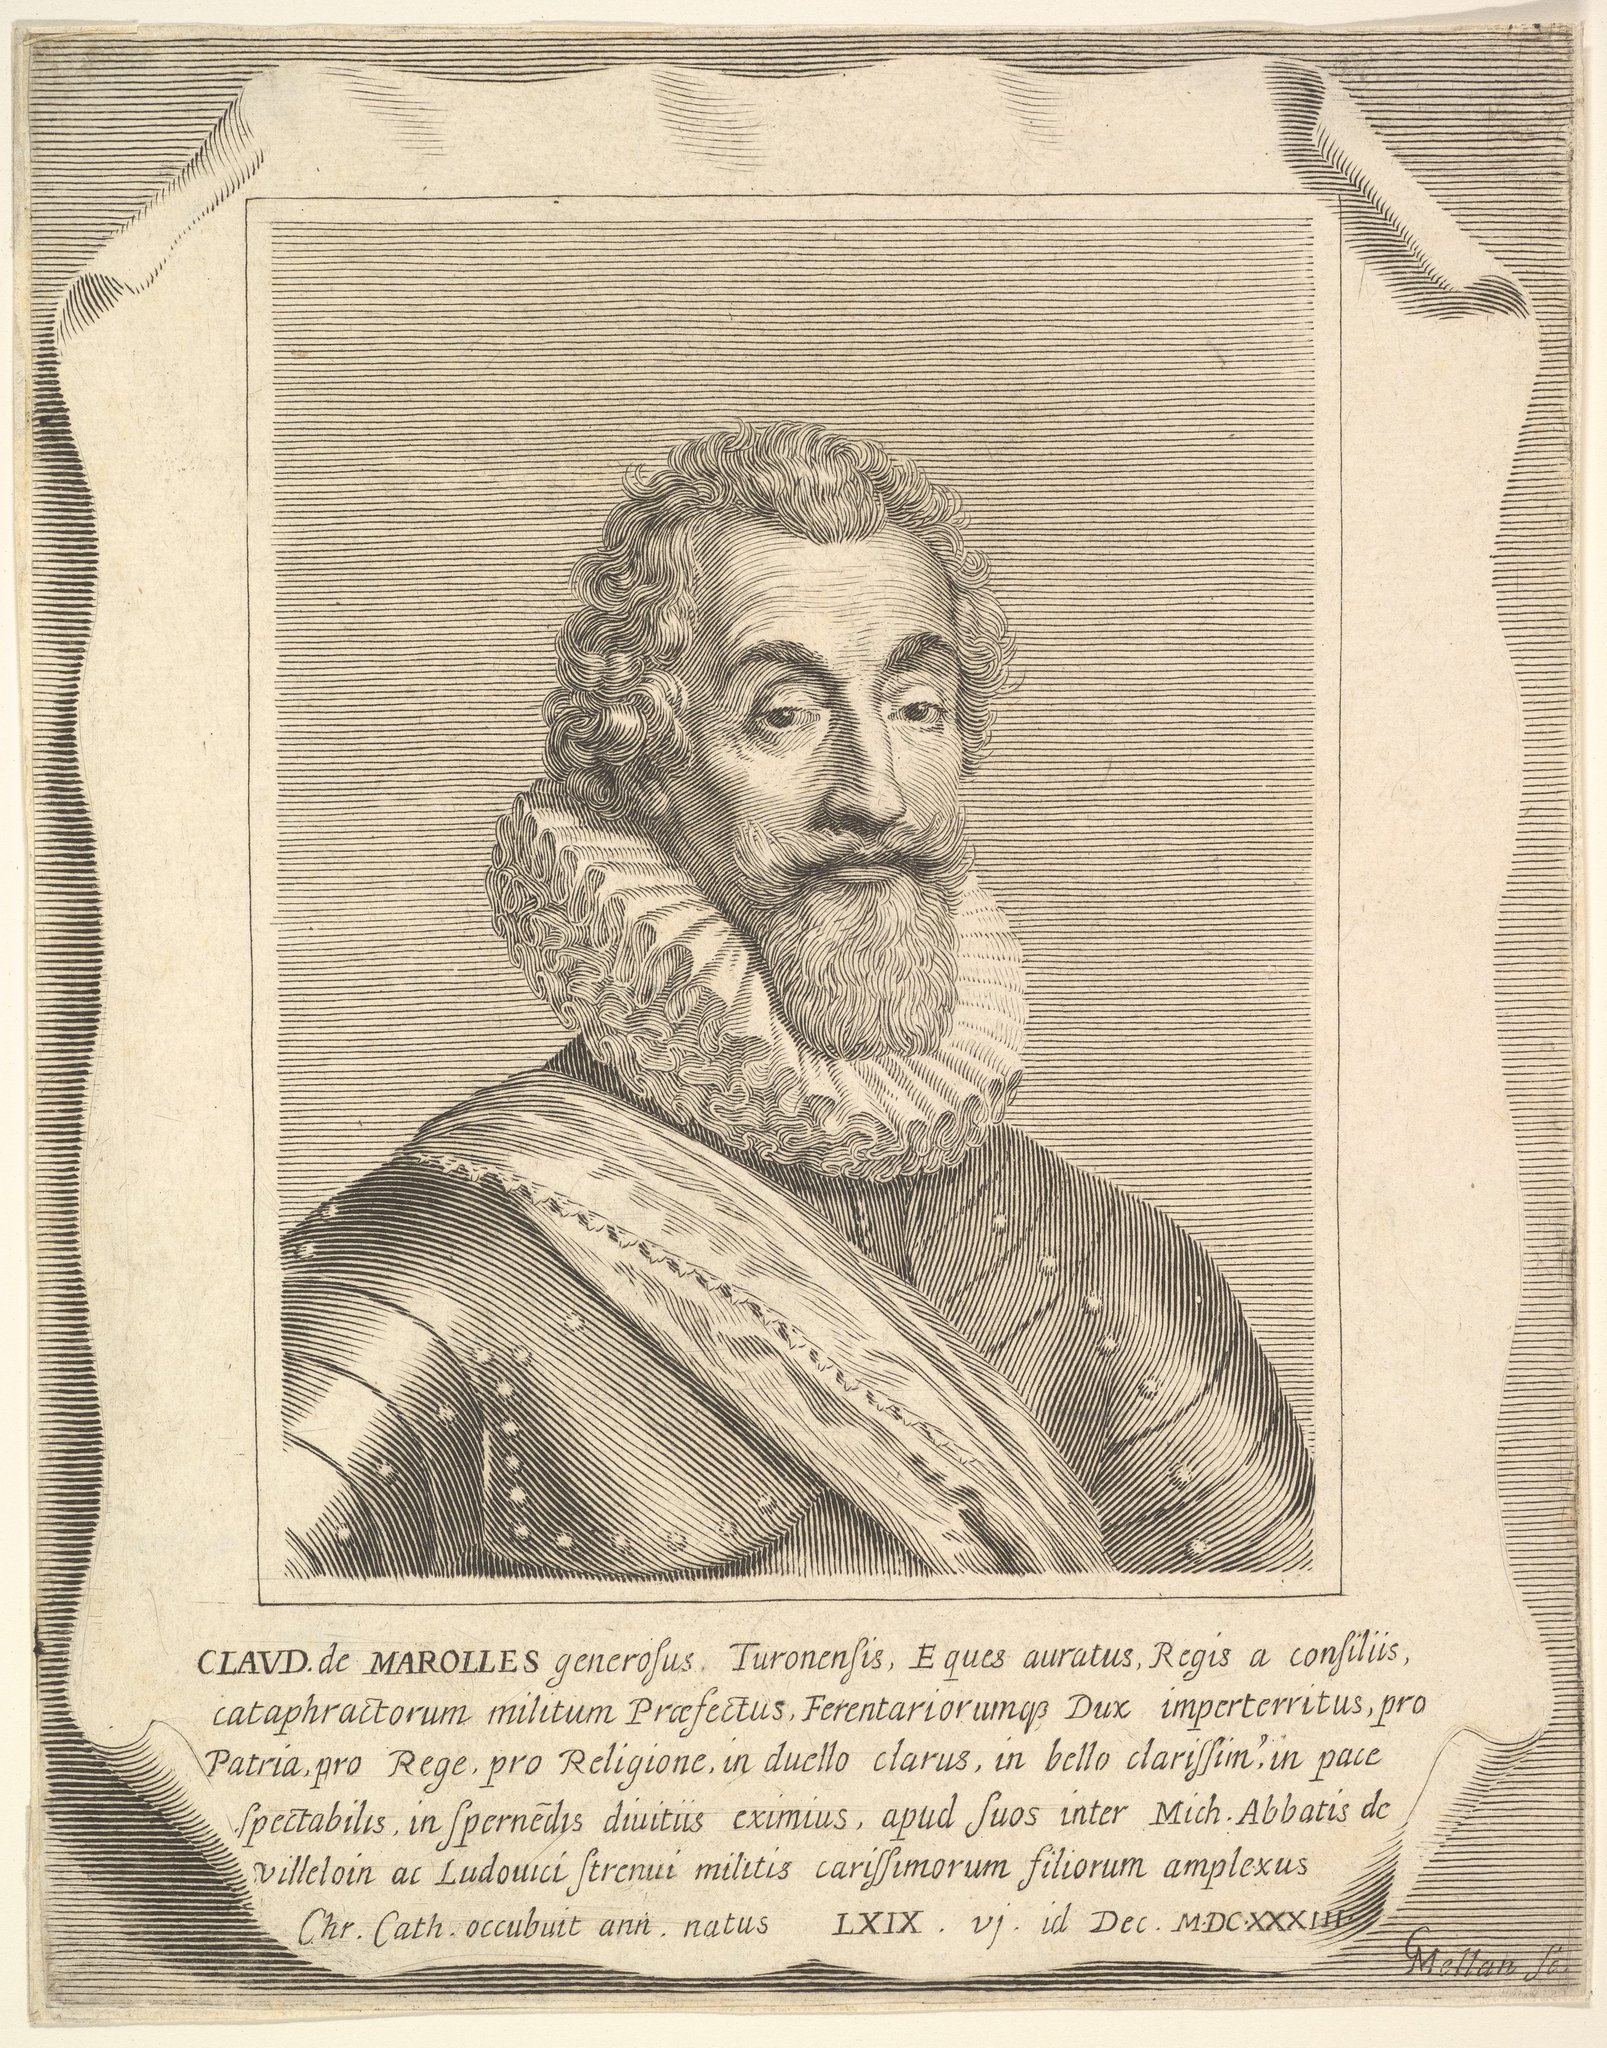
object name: print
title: Portrait of Claude de Marolles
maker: claude mellan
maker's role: artist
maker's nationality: french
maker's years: 1598-1688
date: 1600-1688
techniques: engraving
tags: men,portraits